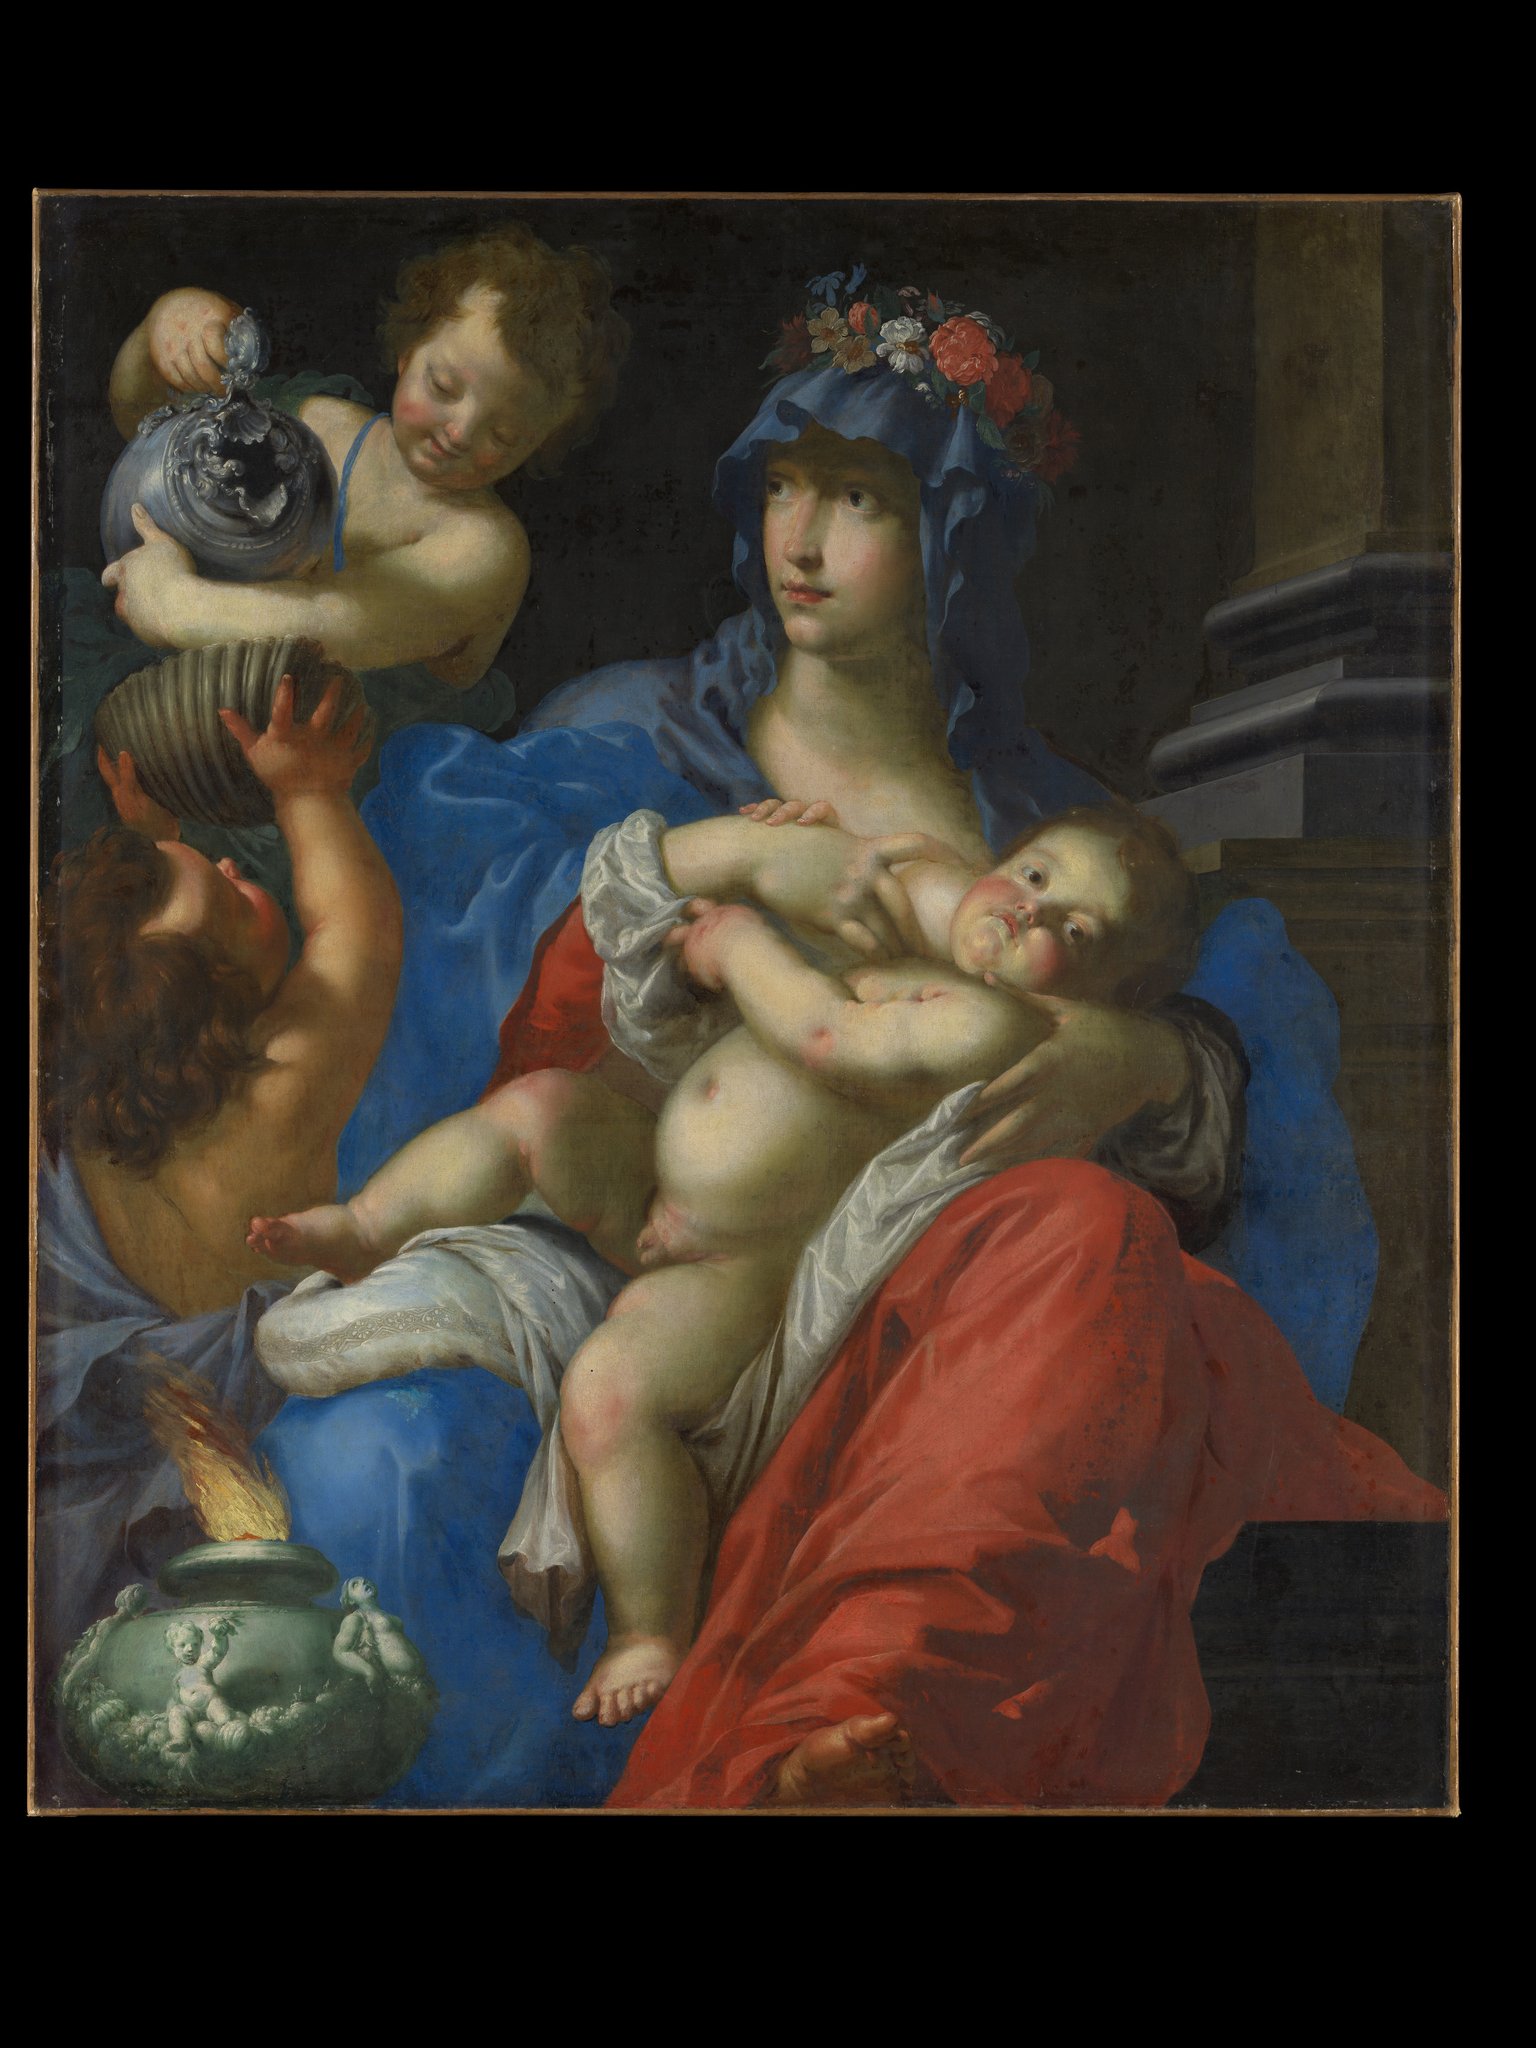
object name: painting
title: Charity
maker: cesare dandini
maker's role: artist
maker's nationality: italian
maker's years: 1596-1657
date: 1630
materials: canvas, oil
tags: infants,women,fire,pitchers,allegory